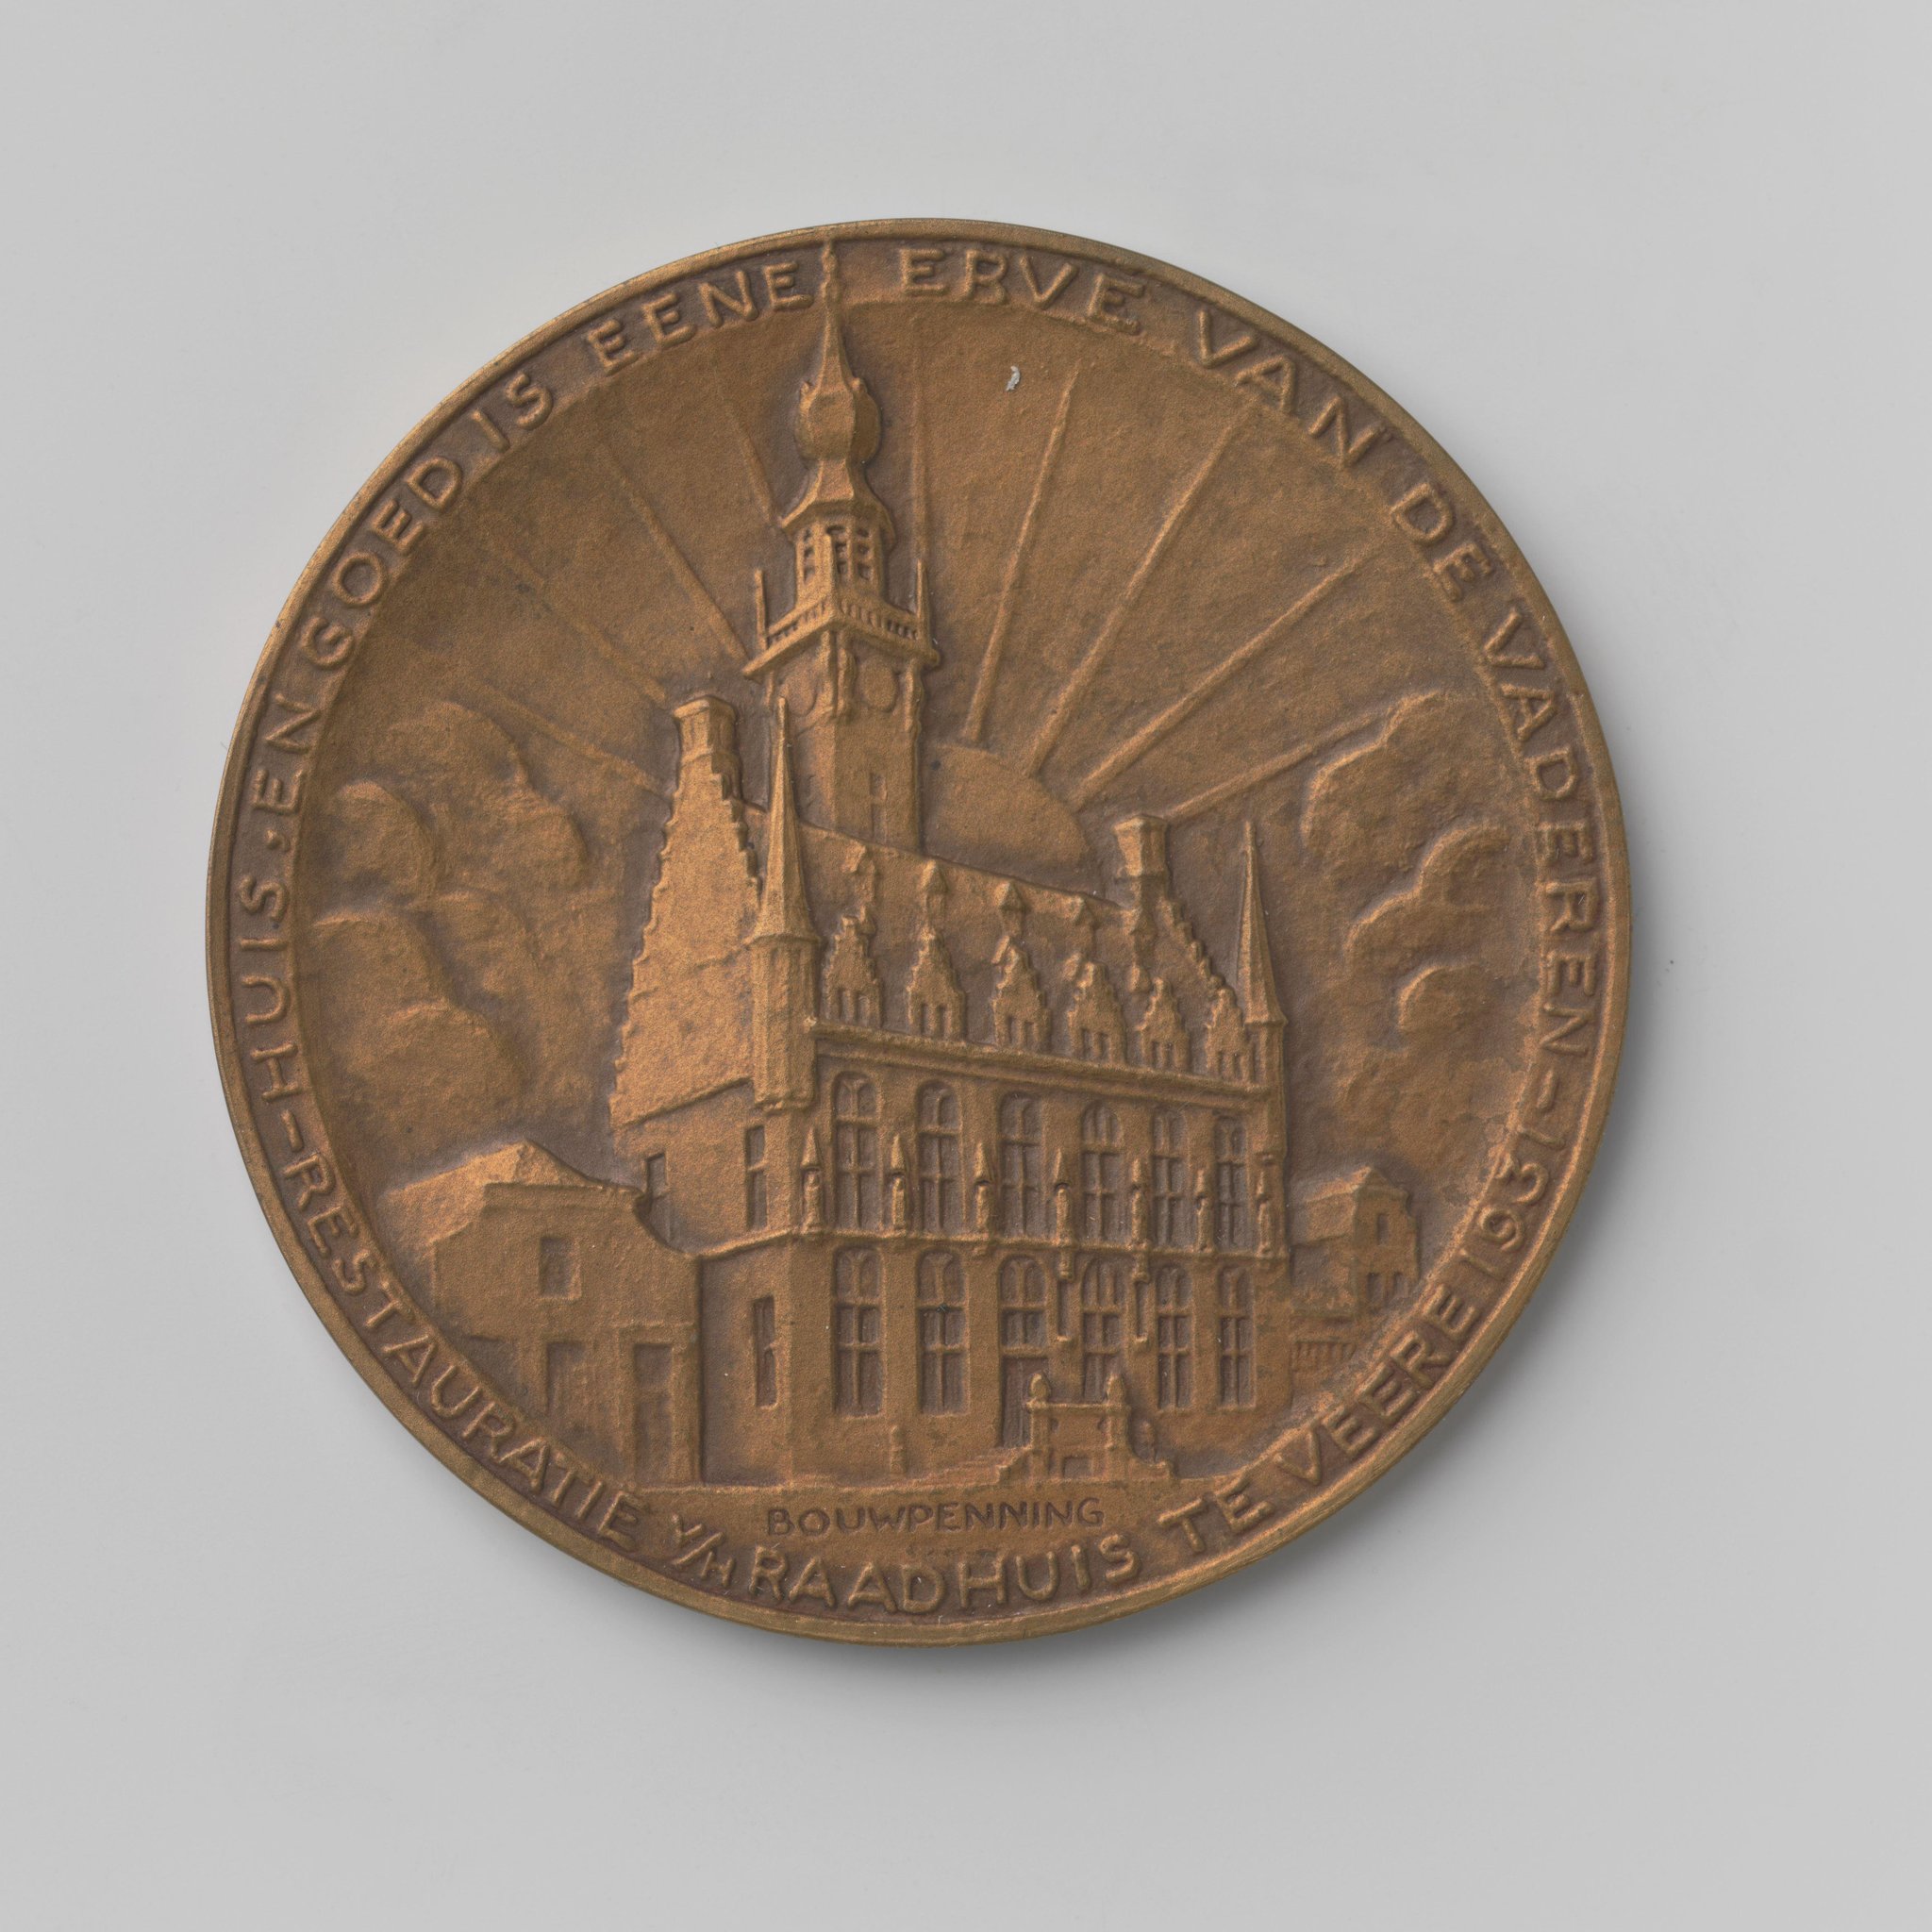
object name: history medal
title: Bouwpenning tot bevordering van het herstel van het Raadhuis te Veere 1931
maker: henk etienne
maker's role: sculptor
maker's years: 1895-1968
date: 1931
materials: bronze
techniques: striking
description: Bronzen penning, op de voorzijde Veere's Raadhuis tegen een stralende zon, met afsnedetekst en omschrift, op de keerzijde een kransvormig lint waarop de gekroonde wapenschilden van Nederland, Zeelnad en Veere, met omschrift, met verklaring.